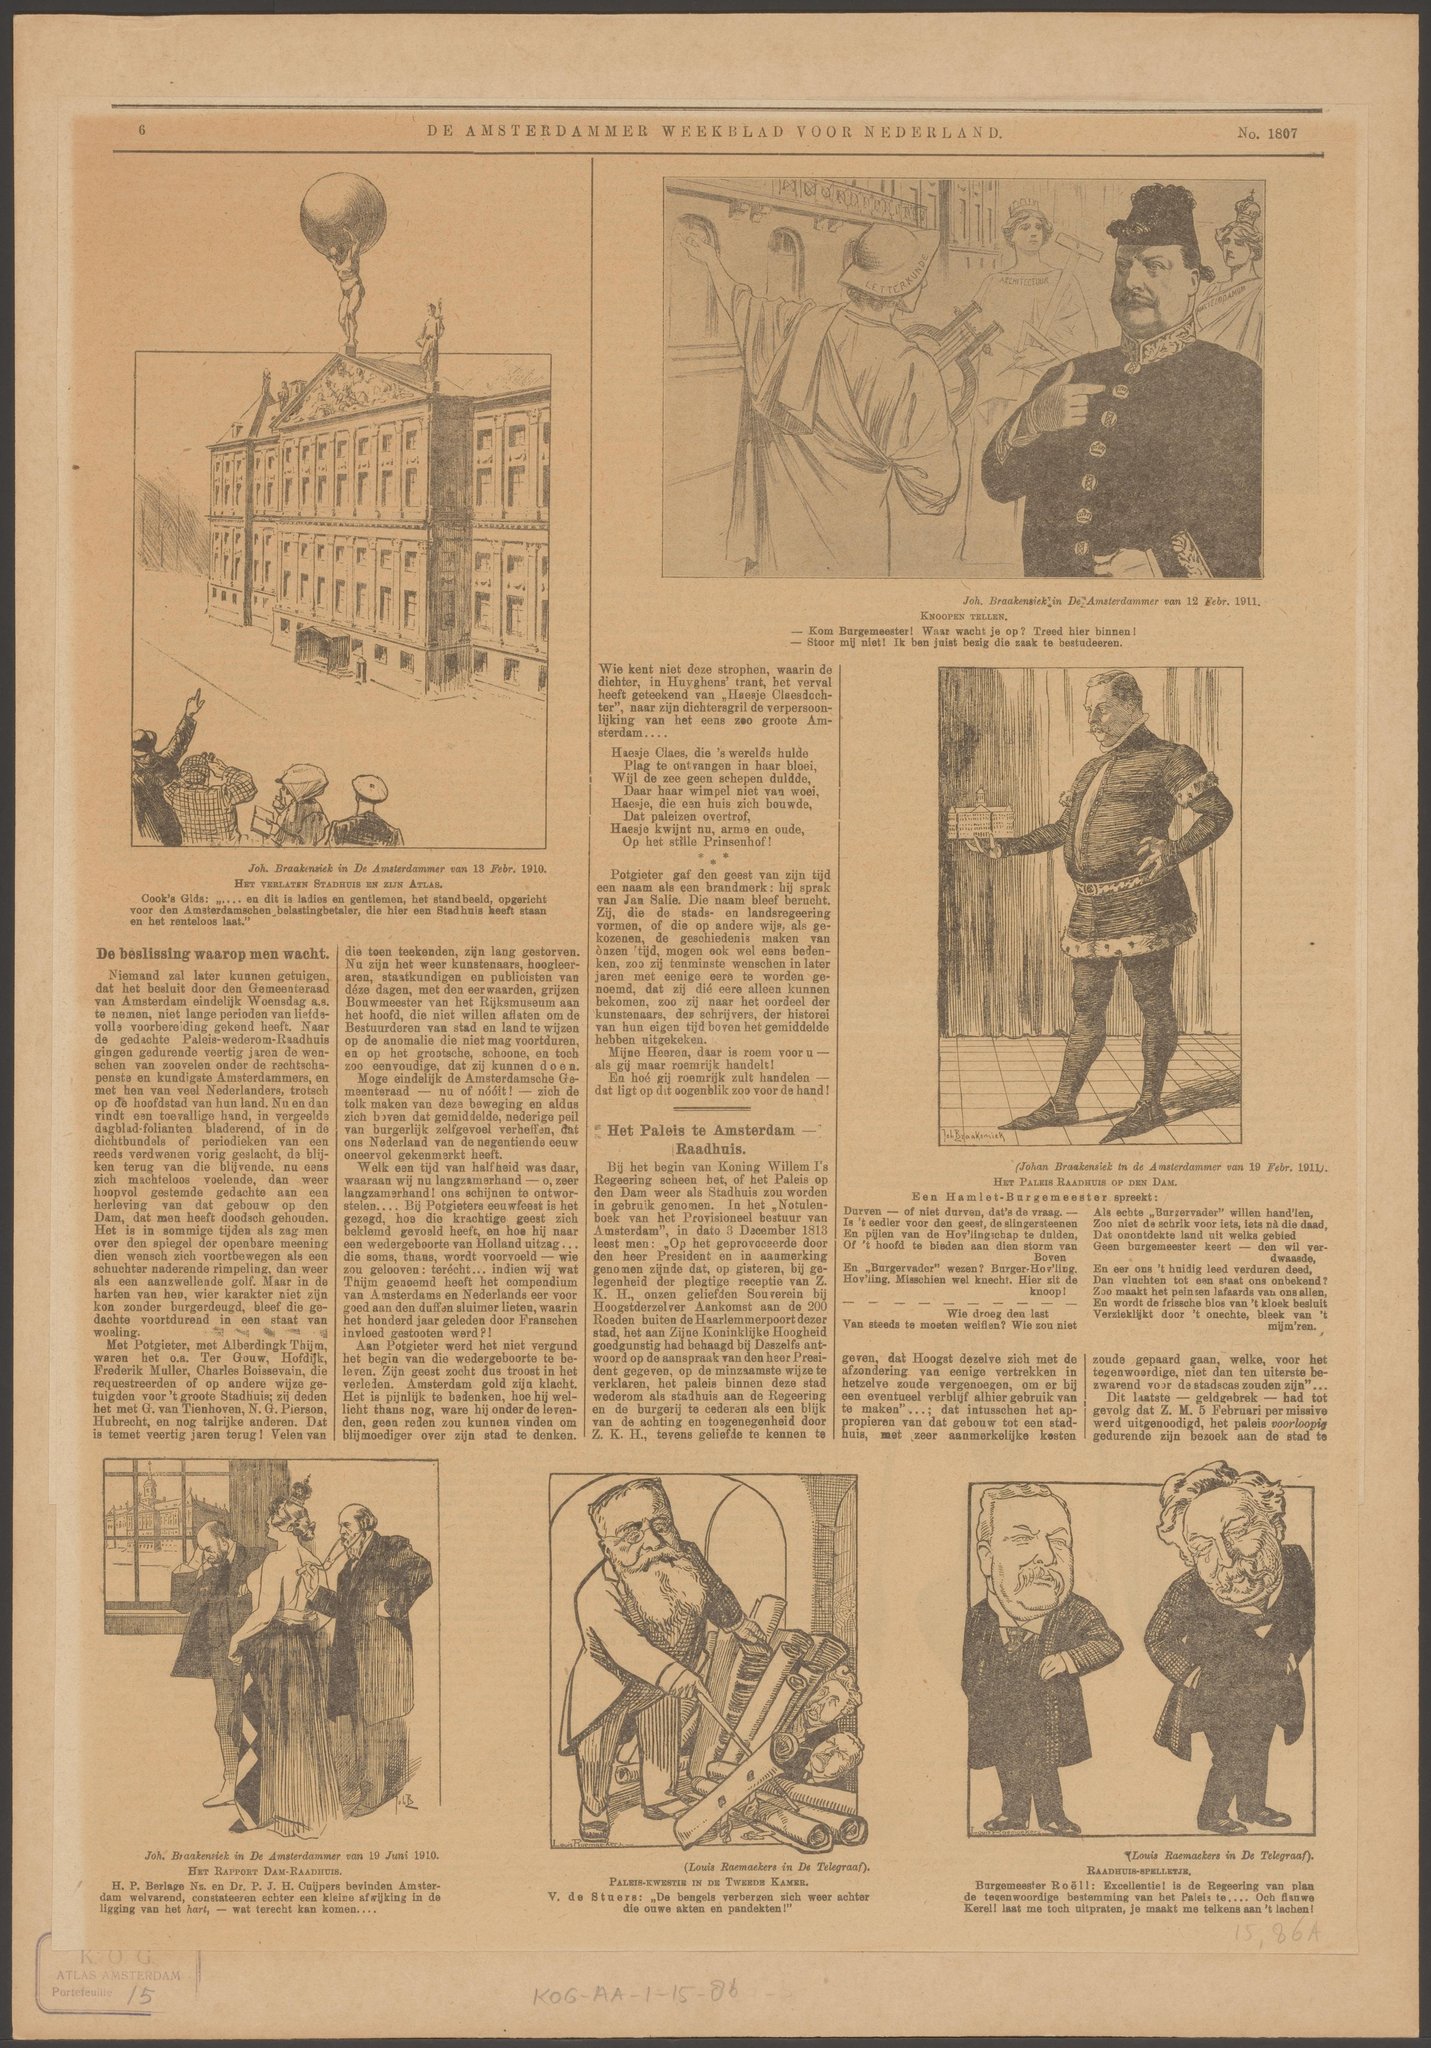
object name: cartoon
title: Bladzijde met spotprenten over de Paleis-Raadhuiskwestie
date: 1911-1924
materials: paper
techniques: letterpress printing, line block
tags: city-view in general; 'veduta', palace, townhall, royal palace of amsterdam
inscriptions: collector's mark: ‘15’ Lugt 1641b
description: Onderwerpsrubriek binnen de Atlas Amsterdam: Nieuwe Stadhuis op de Dam, van buiten, Kleine steentjes kwestie, Paleis - Raadhuiskwestie.